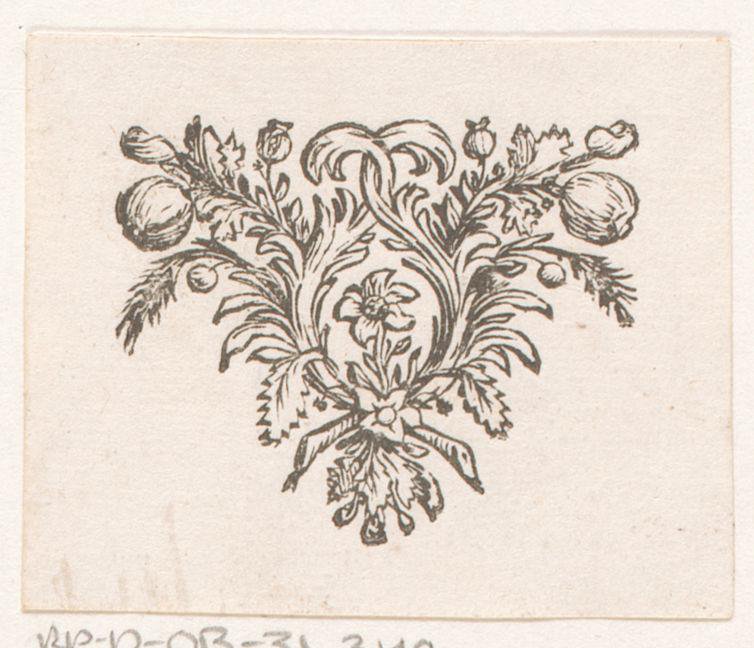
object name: print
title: Vignet met een ornament met bloemen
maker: Anonymous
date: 1600-1699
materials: paper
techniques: woodcut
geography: netherlands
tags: ornaments ~ art, vignette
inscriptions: collector's mark: Lugt 240